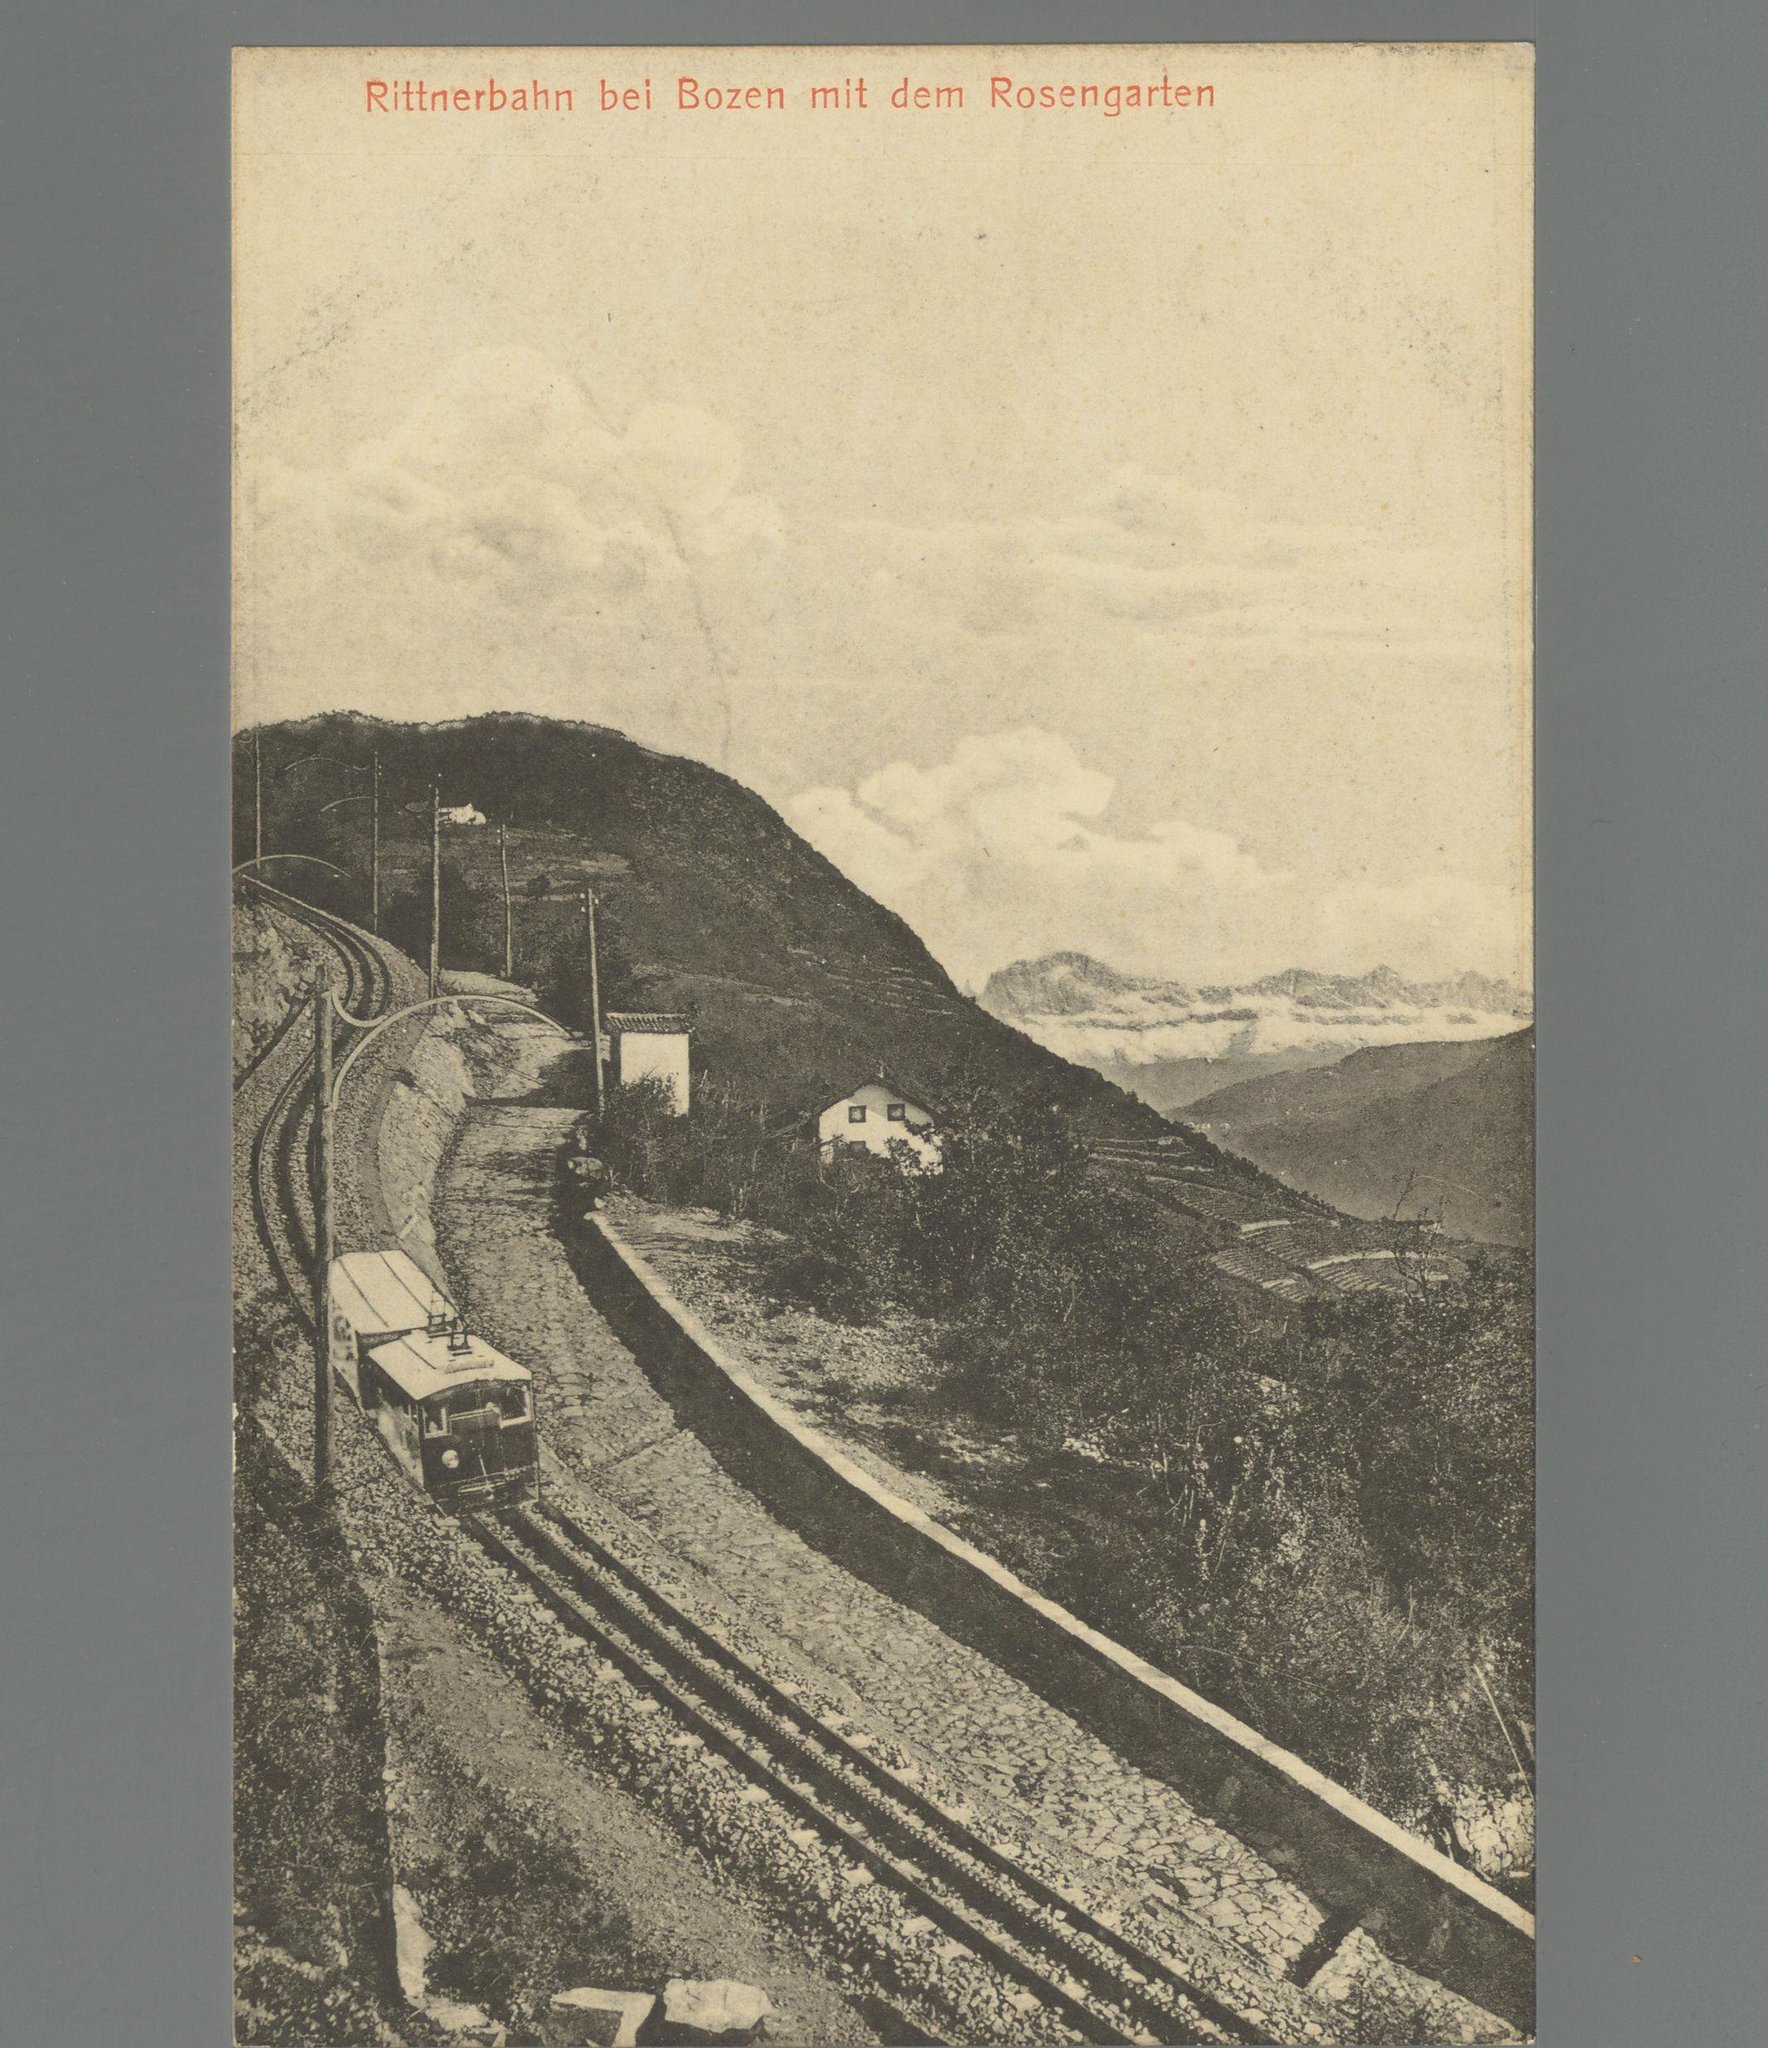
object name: ansichtkaart, prentbriefkaart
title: Rittnerbahn bei Bozen mit dem Rosengarten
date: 1906-1930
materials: cardboard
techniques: photograph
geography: bolzano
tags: railway, train, mountains